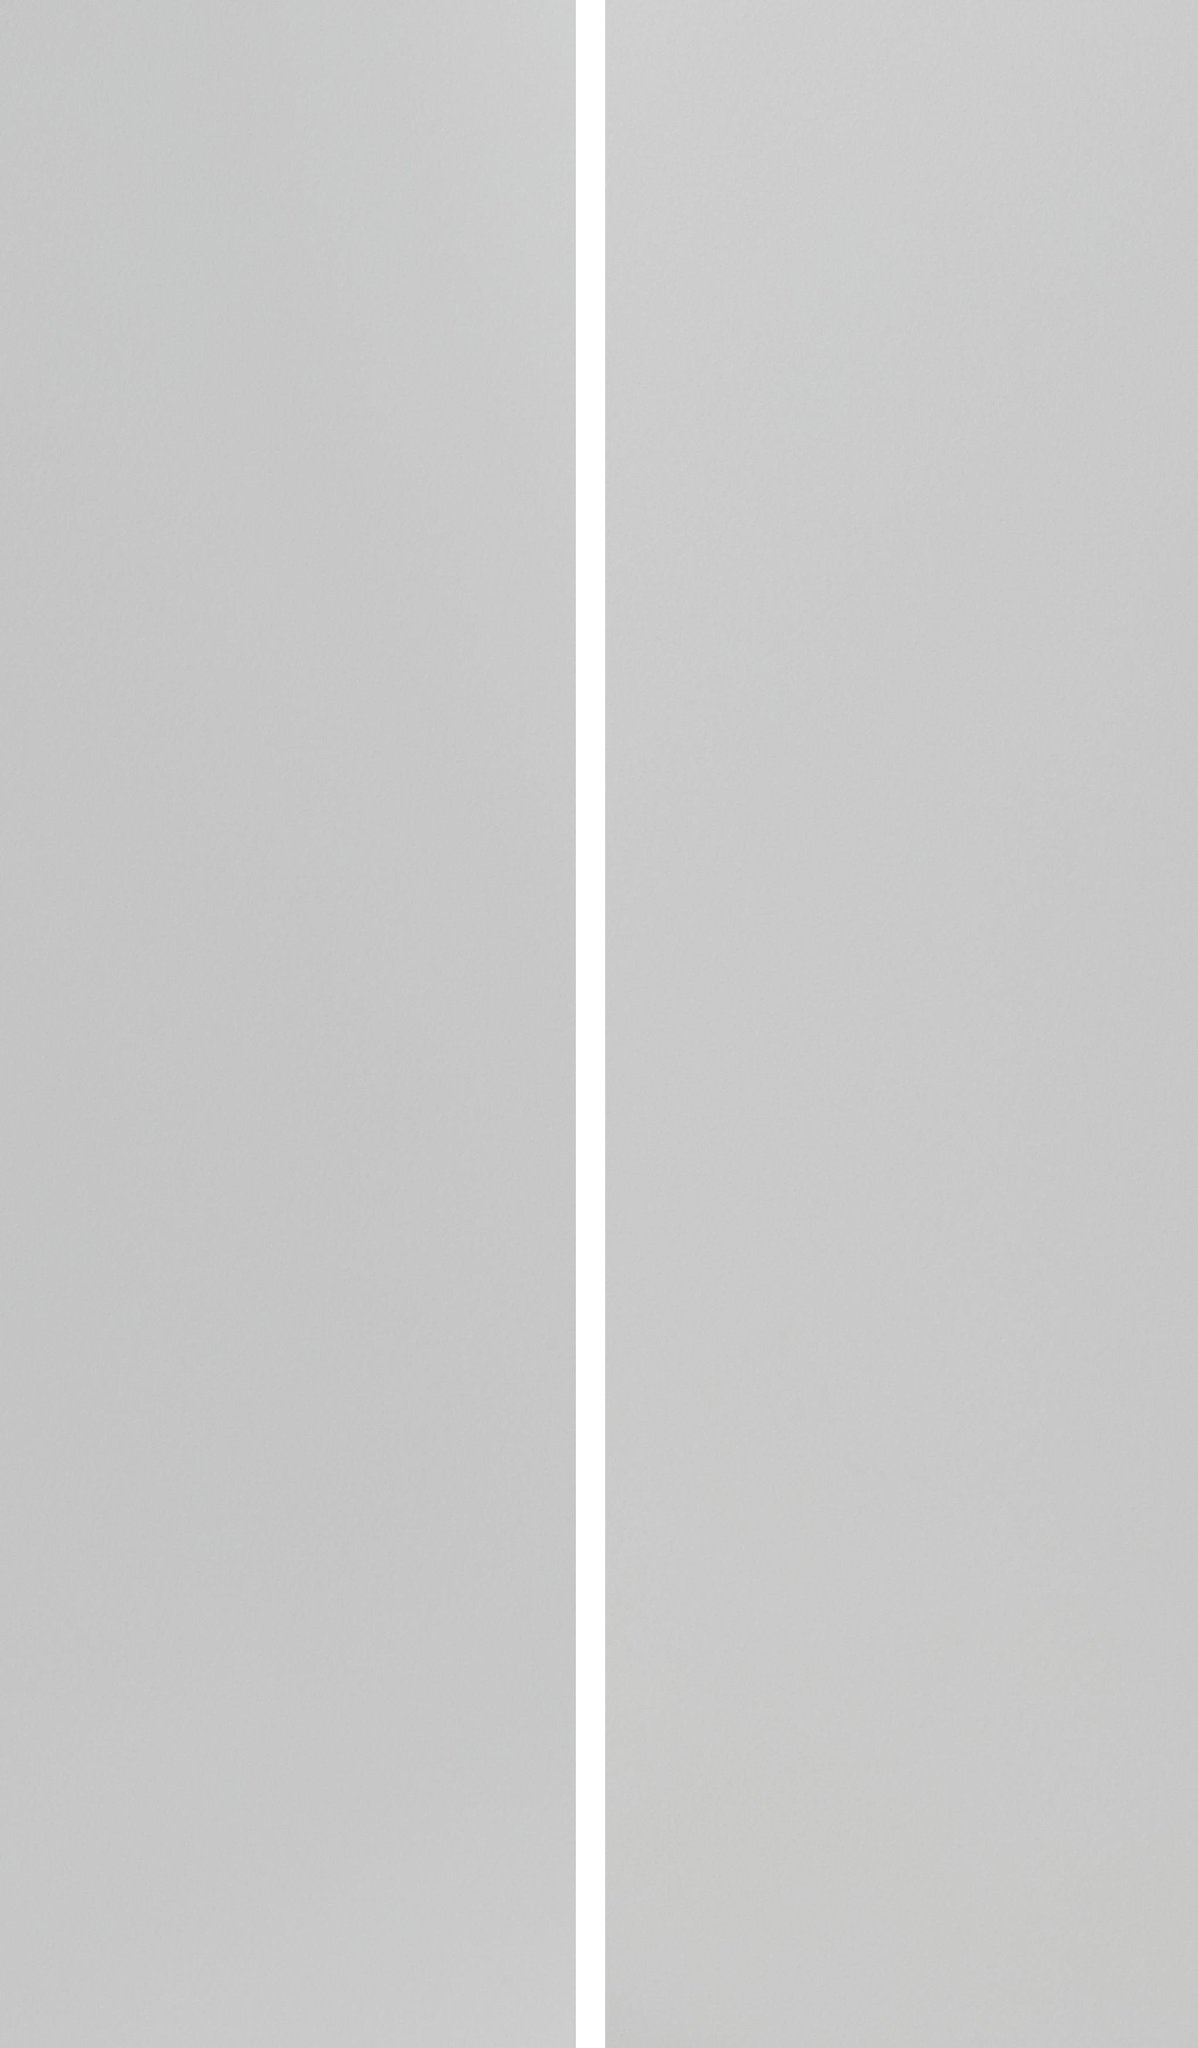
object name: medal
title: Kunst en Wetenschap bevorderende Maatschappij onder de zinspreuk "Vooruitgang door Wetenschap"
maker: hendrik de heus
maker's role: medailleur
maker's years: -1838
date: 1806-1814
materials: linen, silver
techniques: engraving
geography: amsterdam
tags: amsterdam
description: Eenzijdige zilveren penning aan draagoog, draagring en geel lintje met aan beide zijden zwarte streep. Voorzijde: letters V en W in cirkel. Keerzijde: blanco